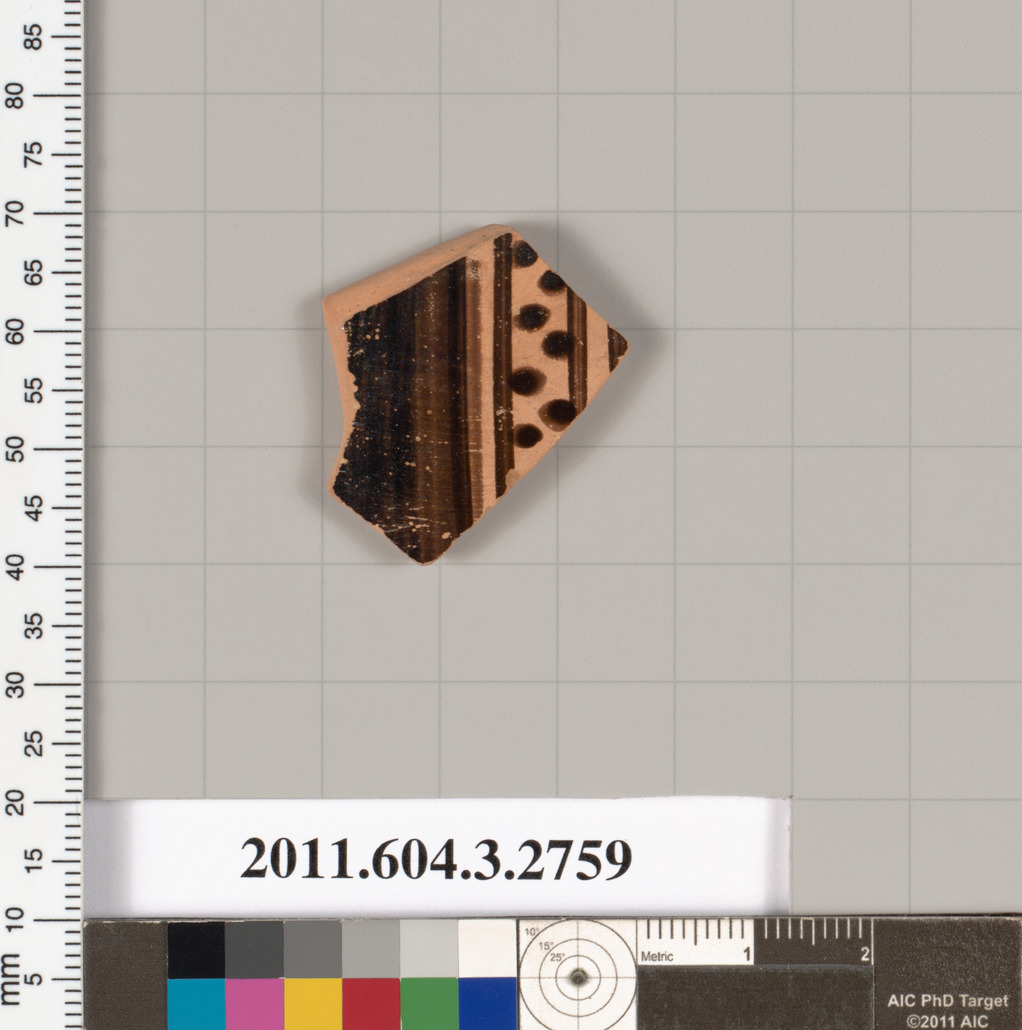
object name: oinochoe fragment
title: Terracotta fragment of an oinochoe (jug)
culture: greek, attic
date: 534-468 BCE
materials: terracotta